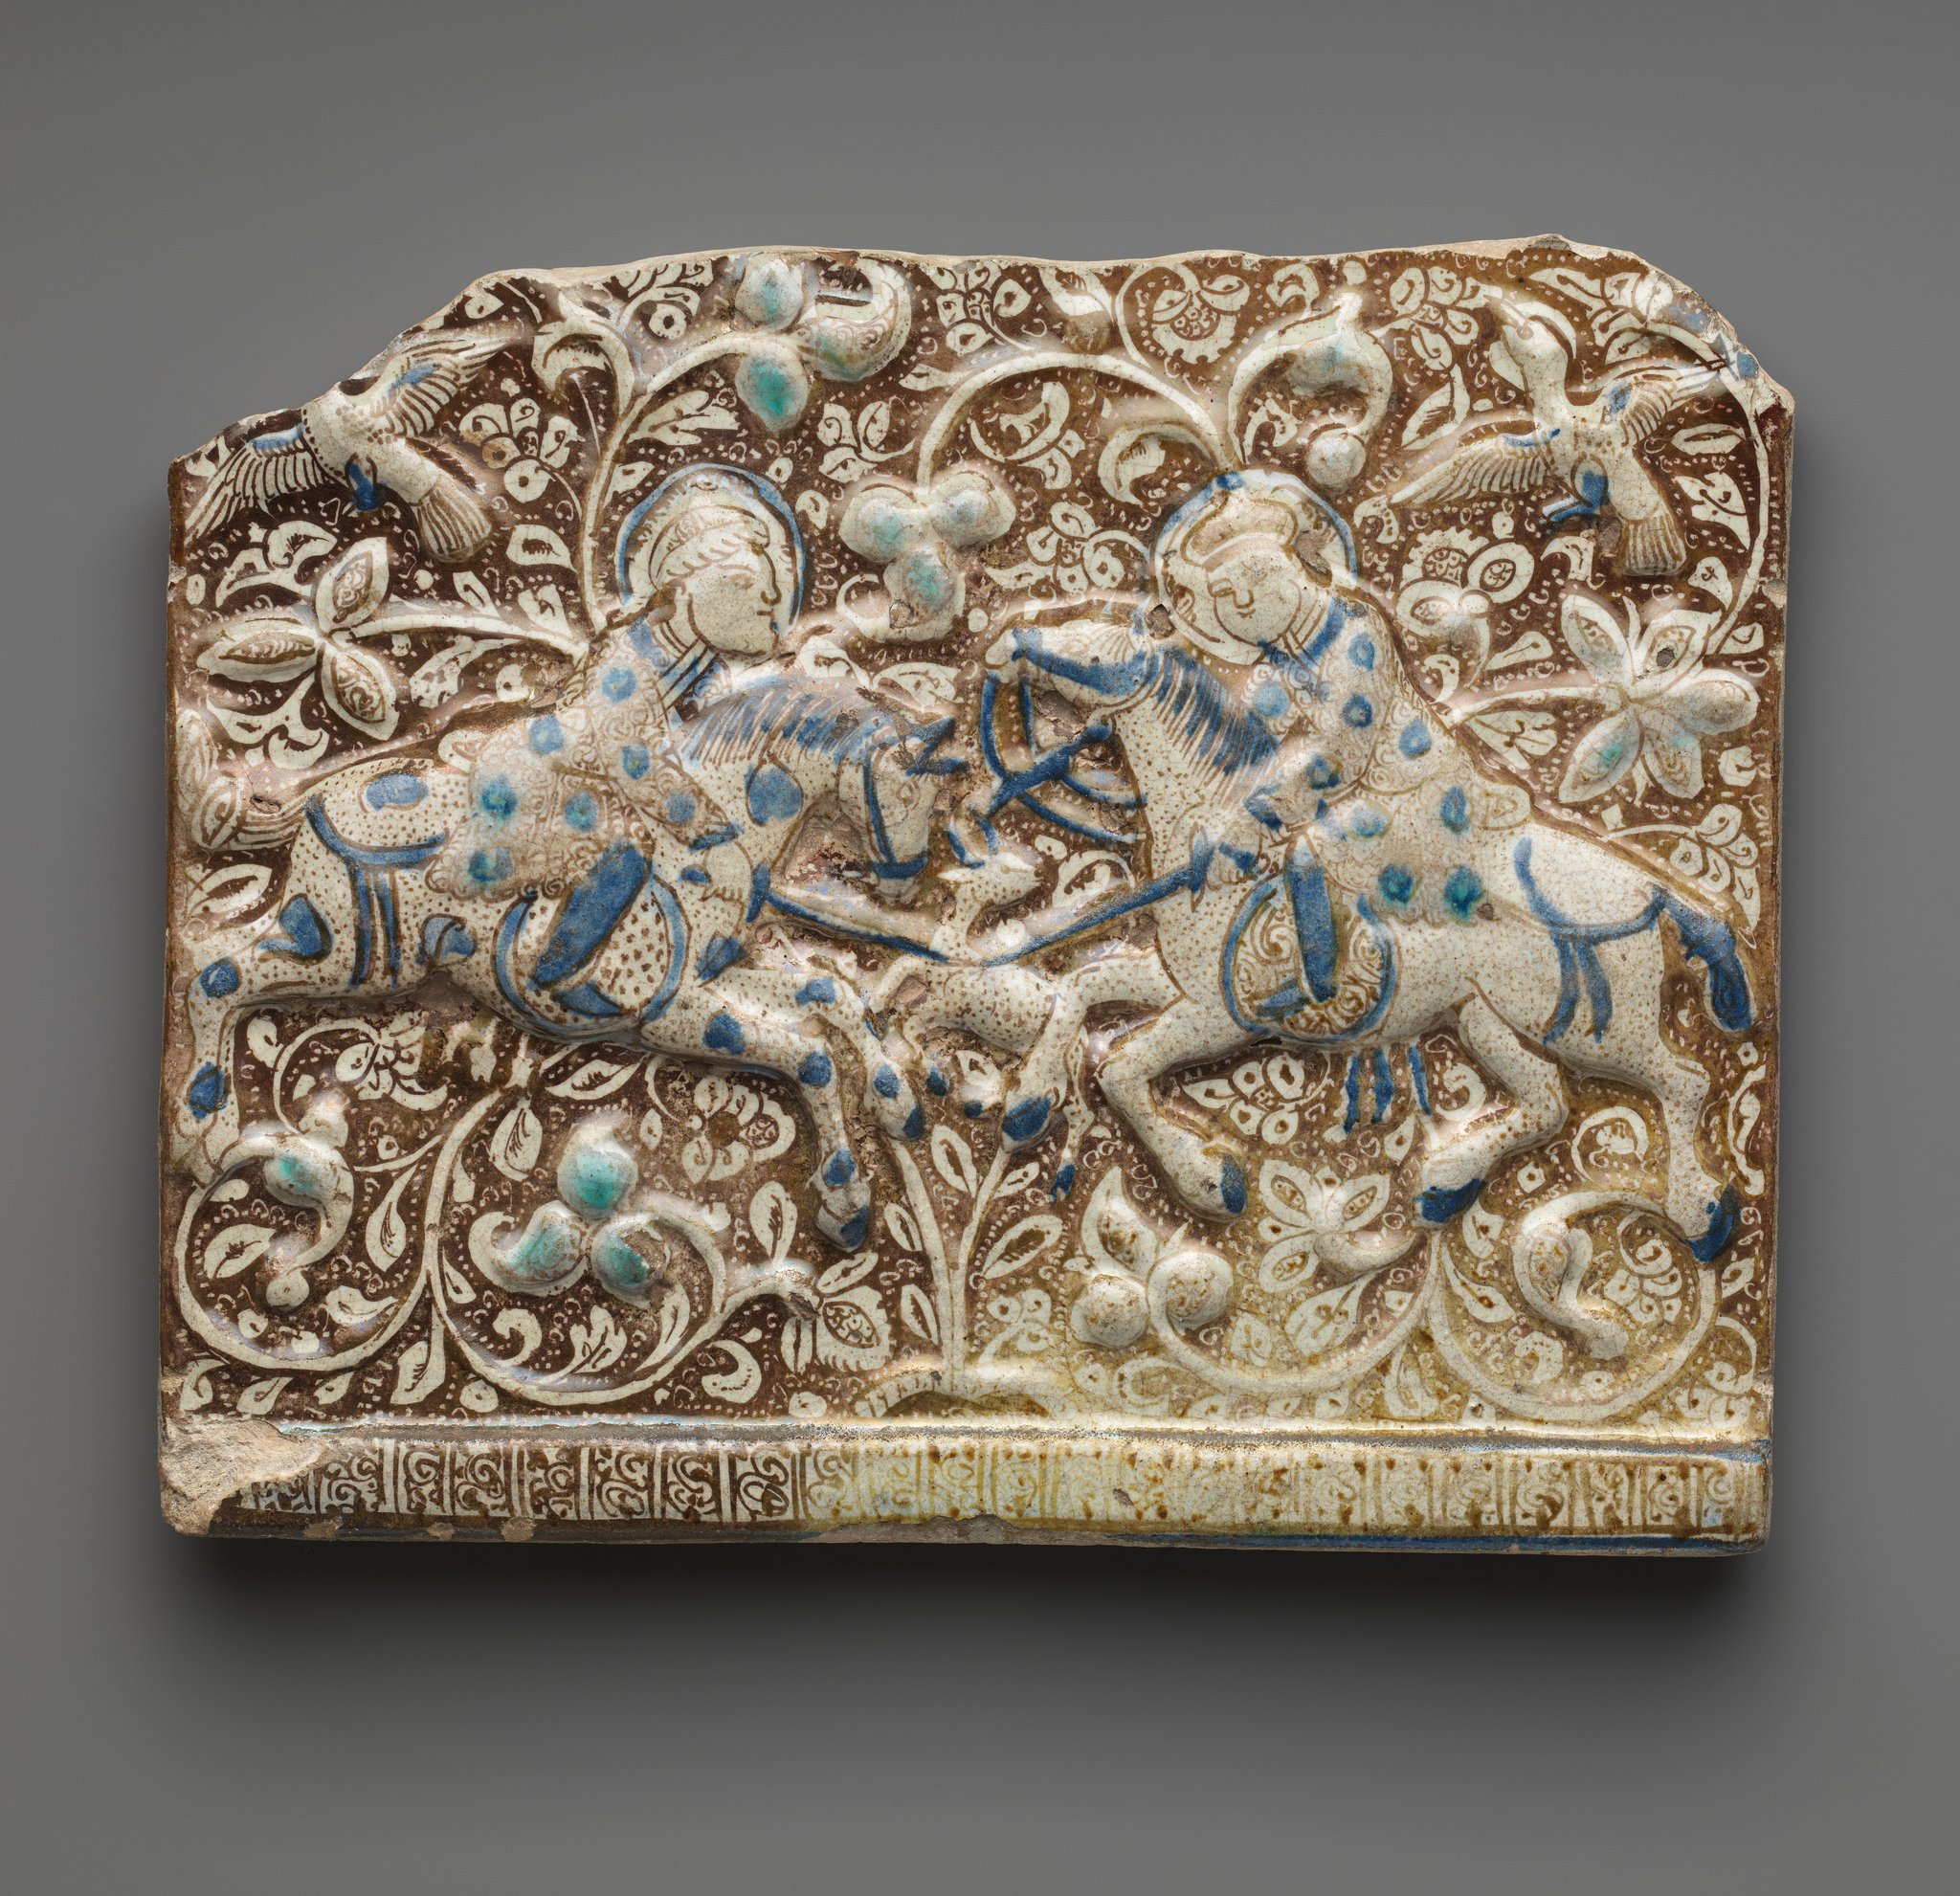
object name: tile from a frieze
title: Frieze Tile with Two Hunters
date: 1251-1300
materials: glaze, stonepaste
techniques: luster painting, molding, painting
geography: iran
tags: birds,men,hunting,horses